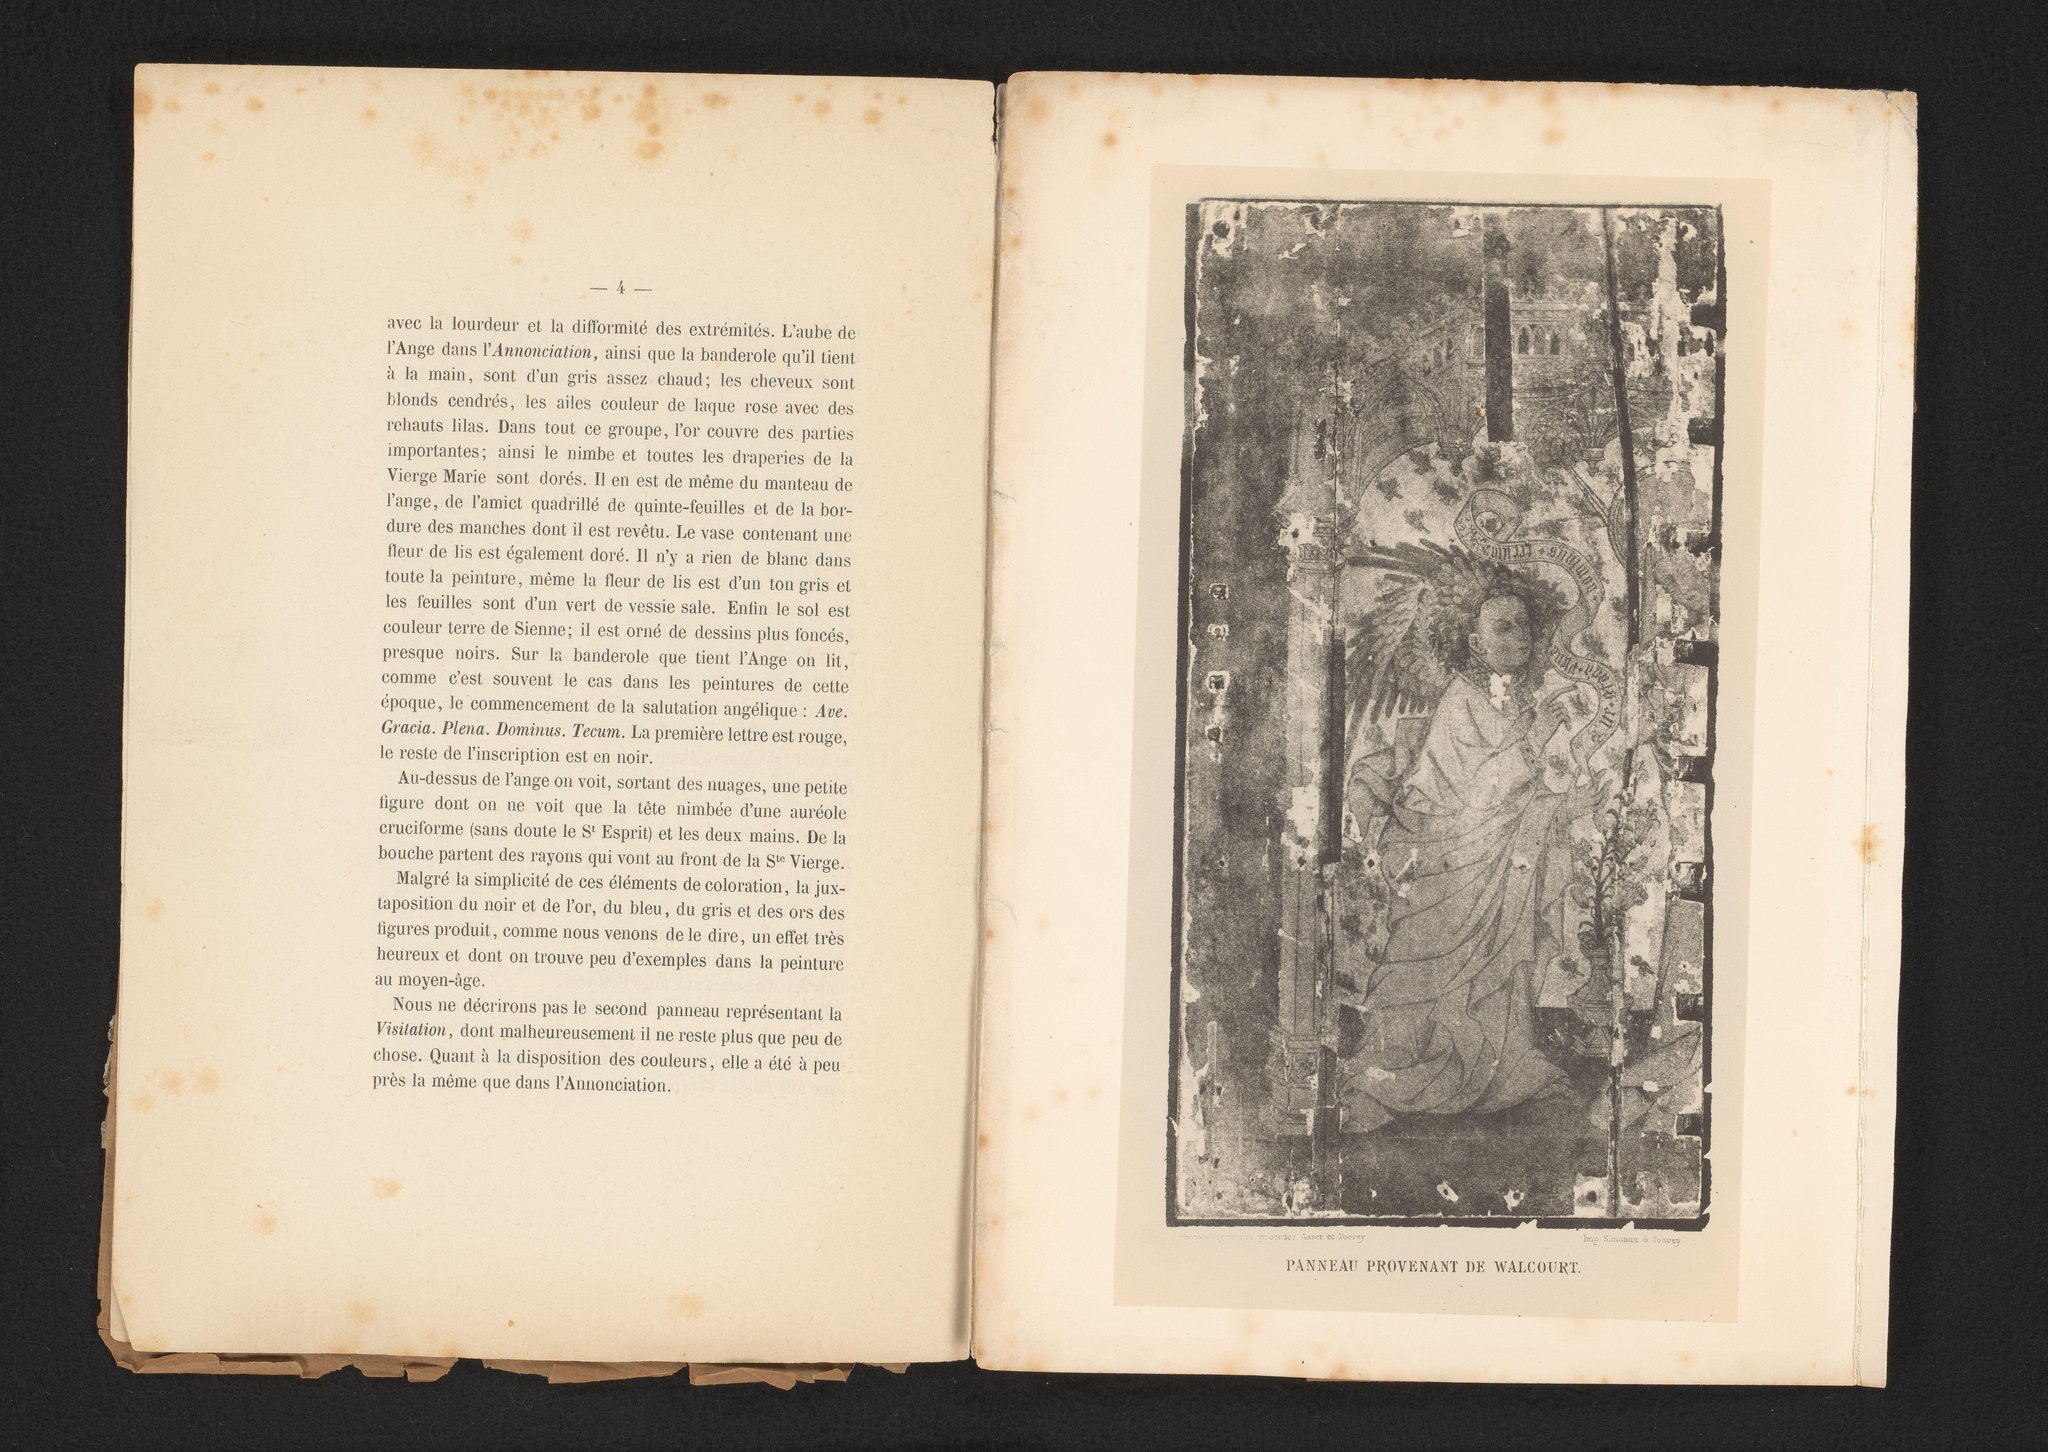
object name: photomechanical print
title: Panneau provenant de Walcourt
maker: Anonymous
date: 1865-1870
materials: paper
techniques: photolithography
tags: painting, drawing and the graphic arts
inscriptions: inscription: ‘Photolithographie procedée Asser et Toovey’